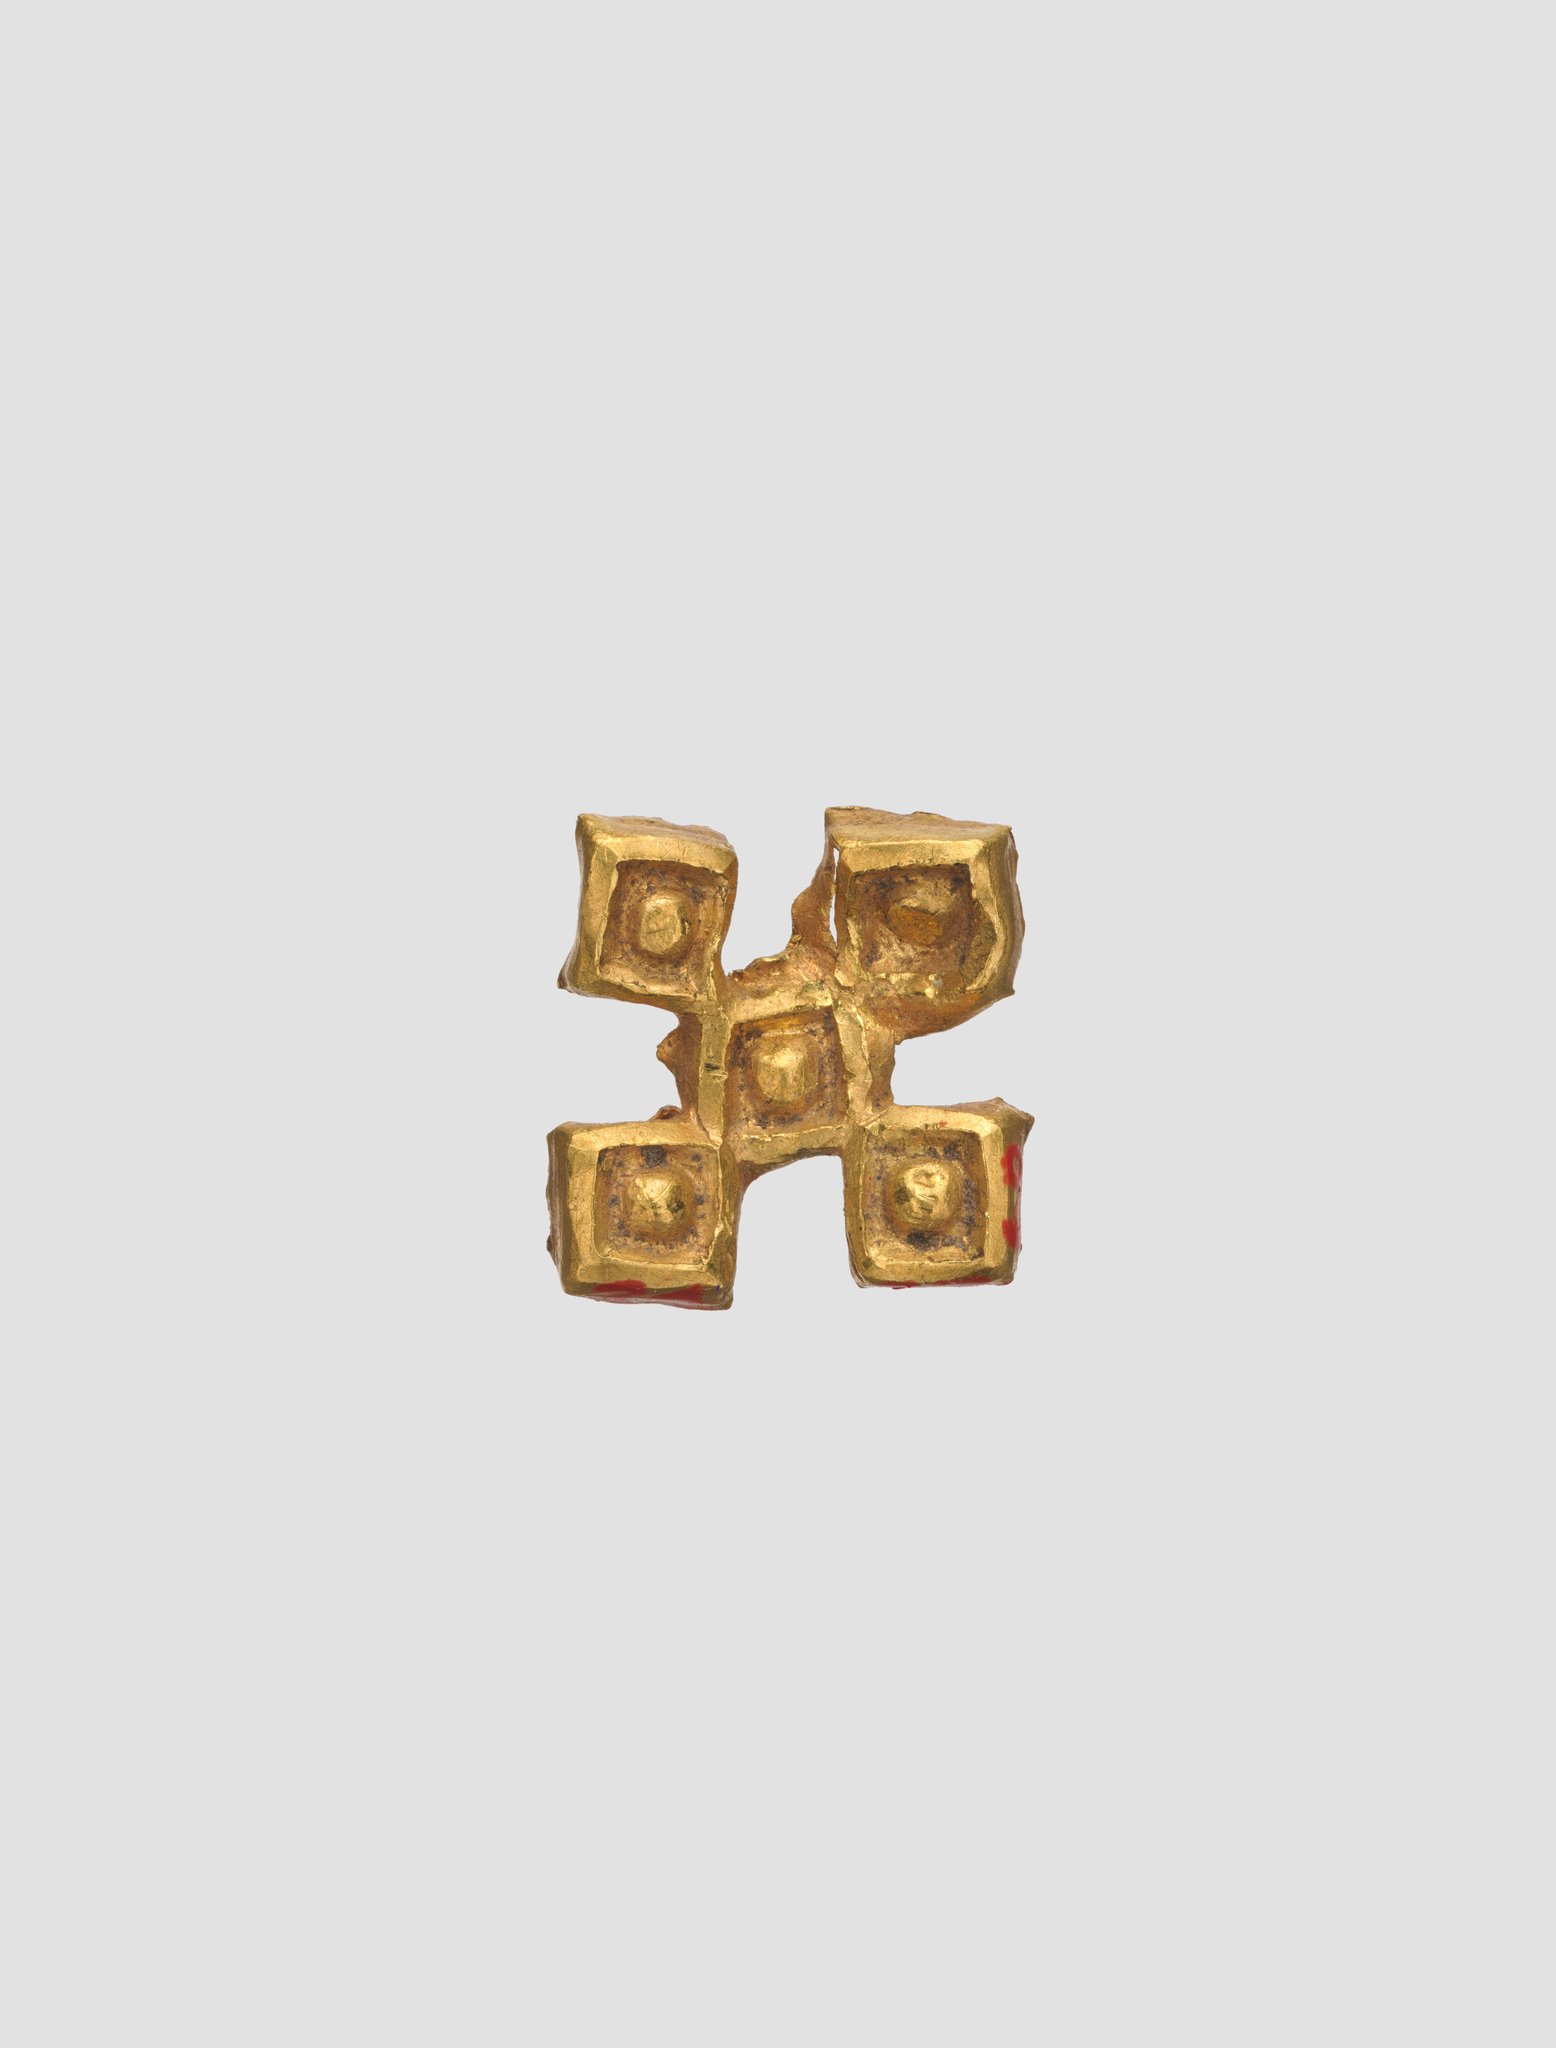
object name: dress ornament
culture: scythian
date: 500-401 BCE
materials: gold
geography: northern black sea region